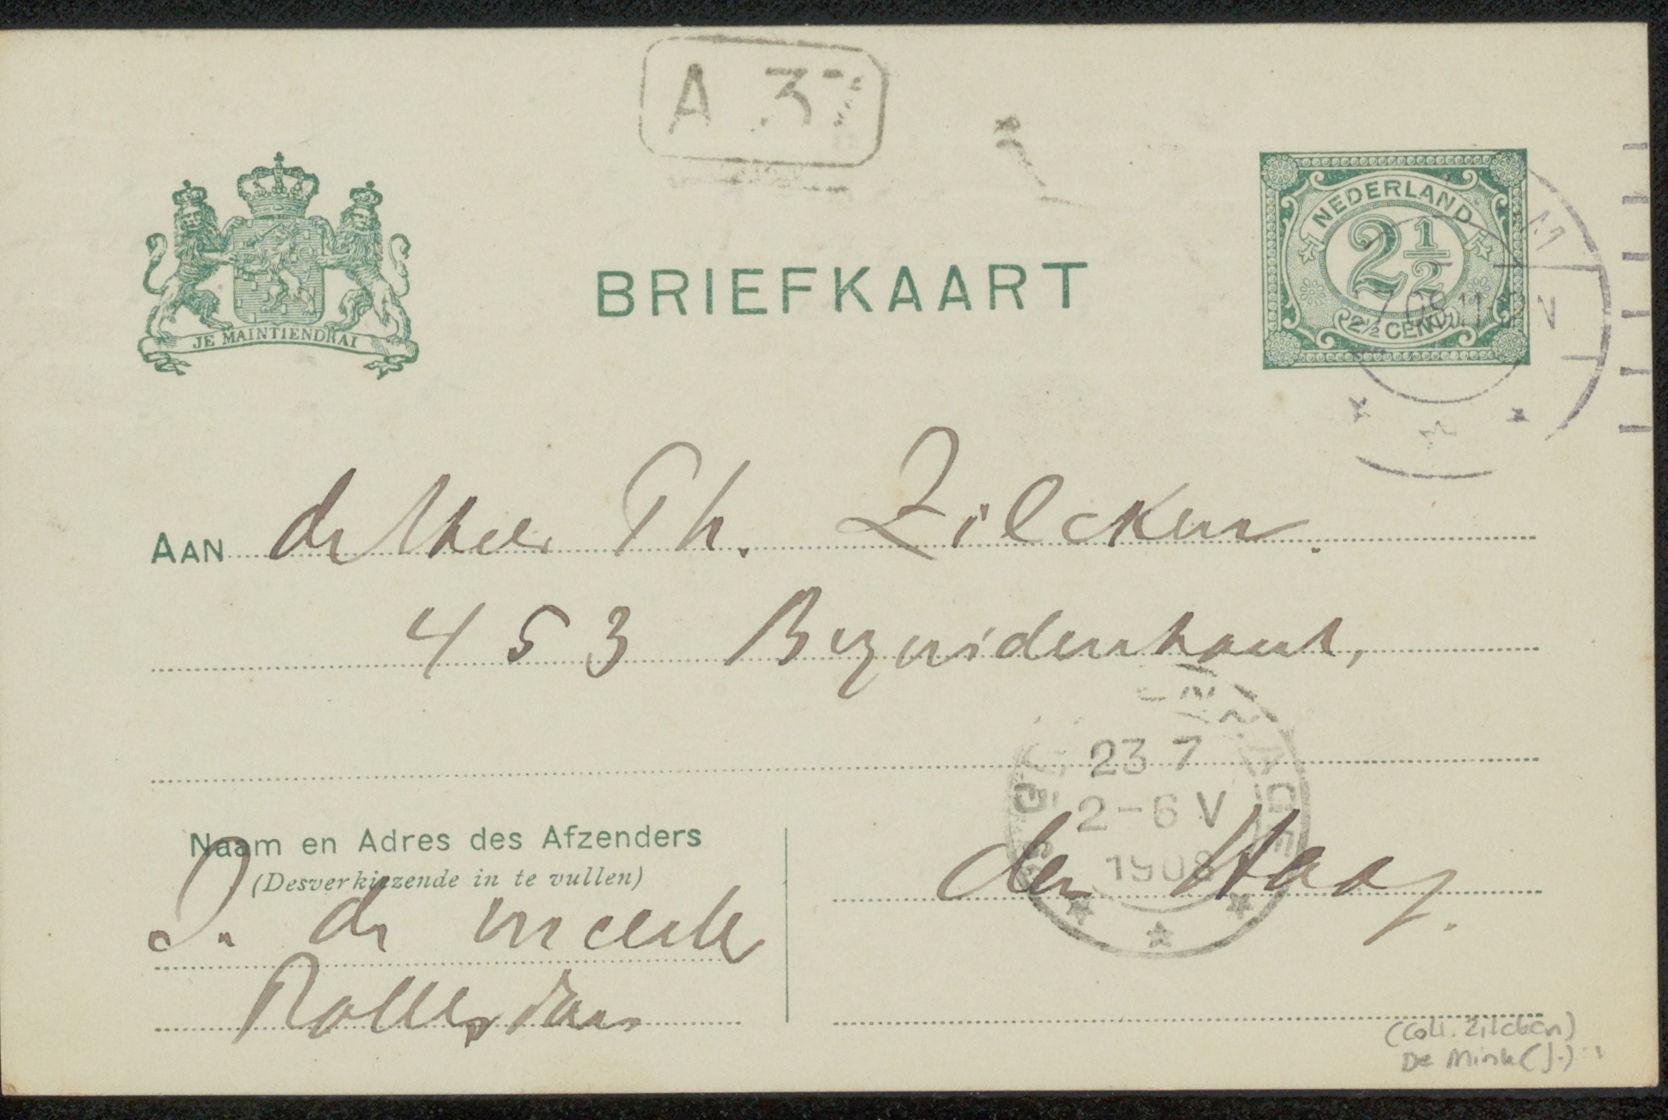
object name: postcard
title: Briefkaart aan Philip Zilcken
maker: j. de mink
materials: cardboard, ink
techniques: pen, printing, writing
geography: rotterdam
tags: the hague, painter, draughtsman, philip zilcken, rotterdam, arnhem